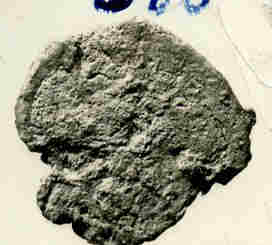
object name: coin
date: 401-1400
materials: copper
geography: iran